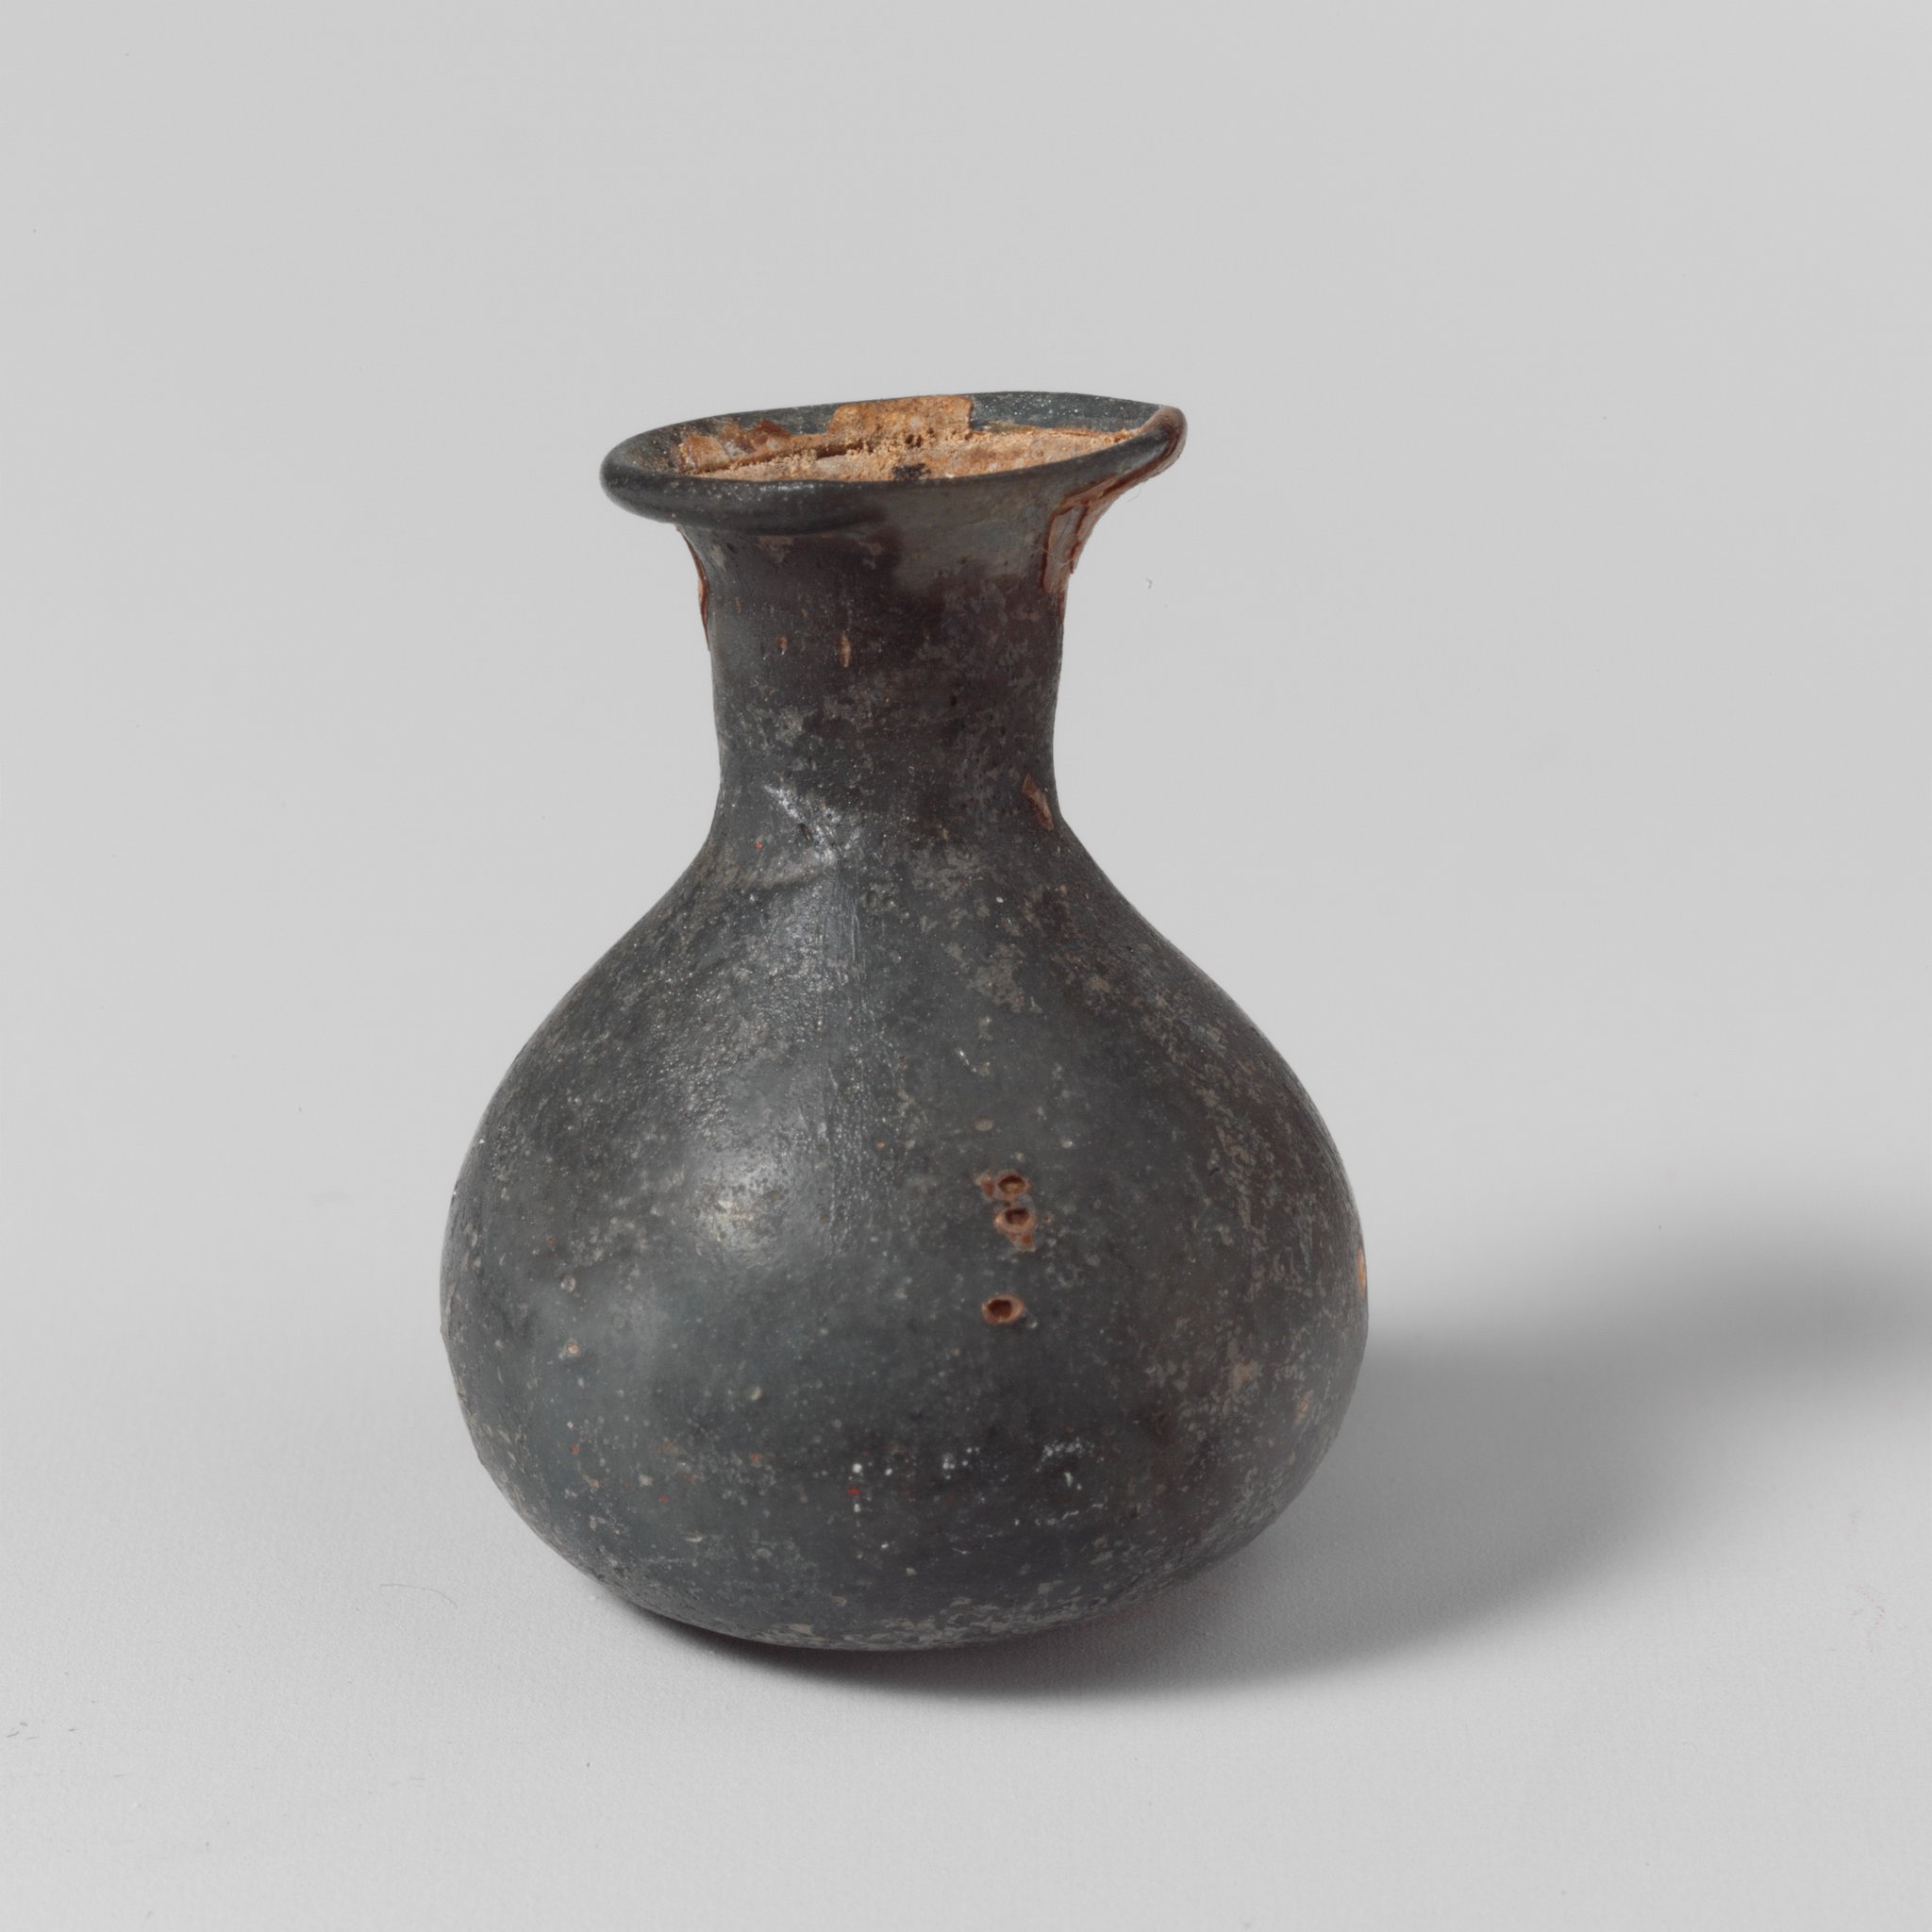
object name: bottle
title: Glass perfume bottle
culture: roman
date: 101-300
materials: glass